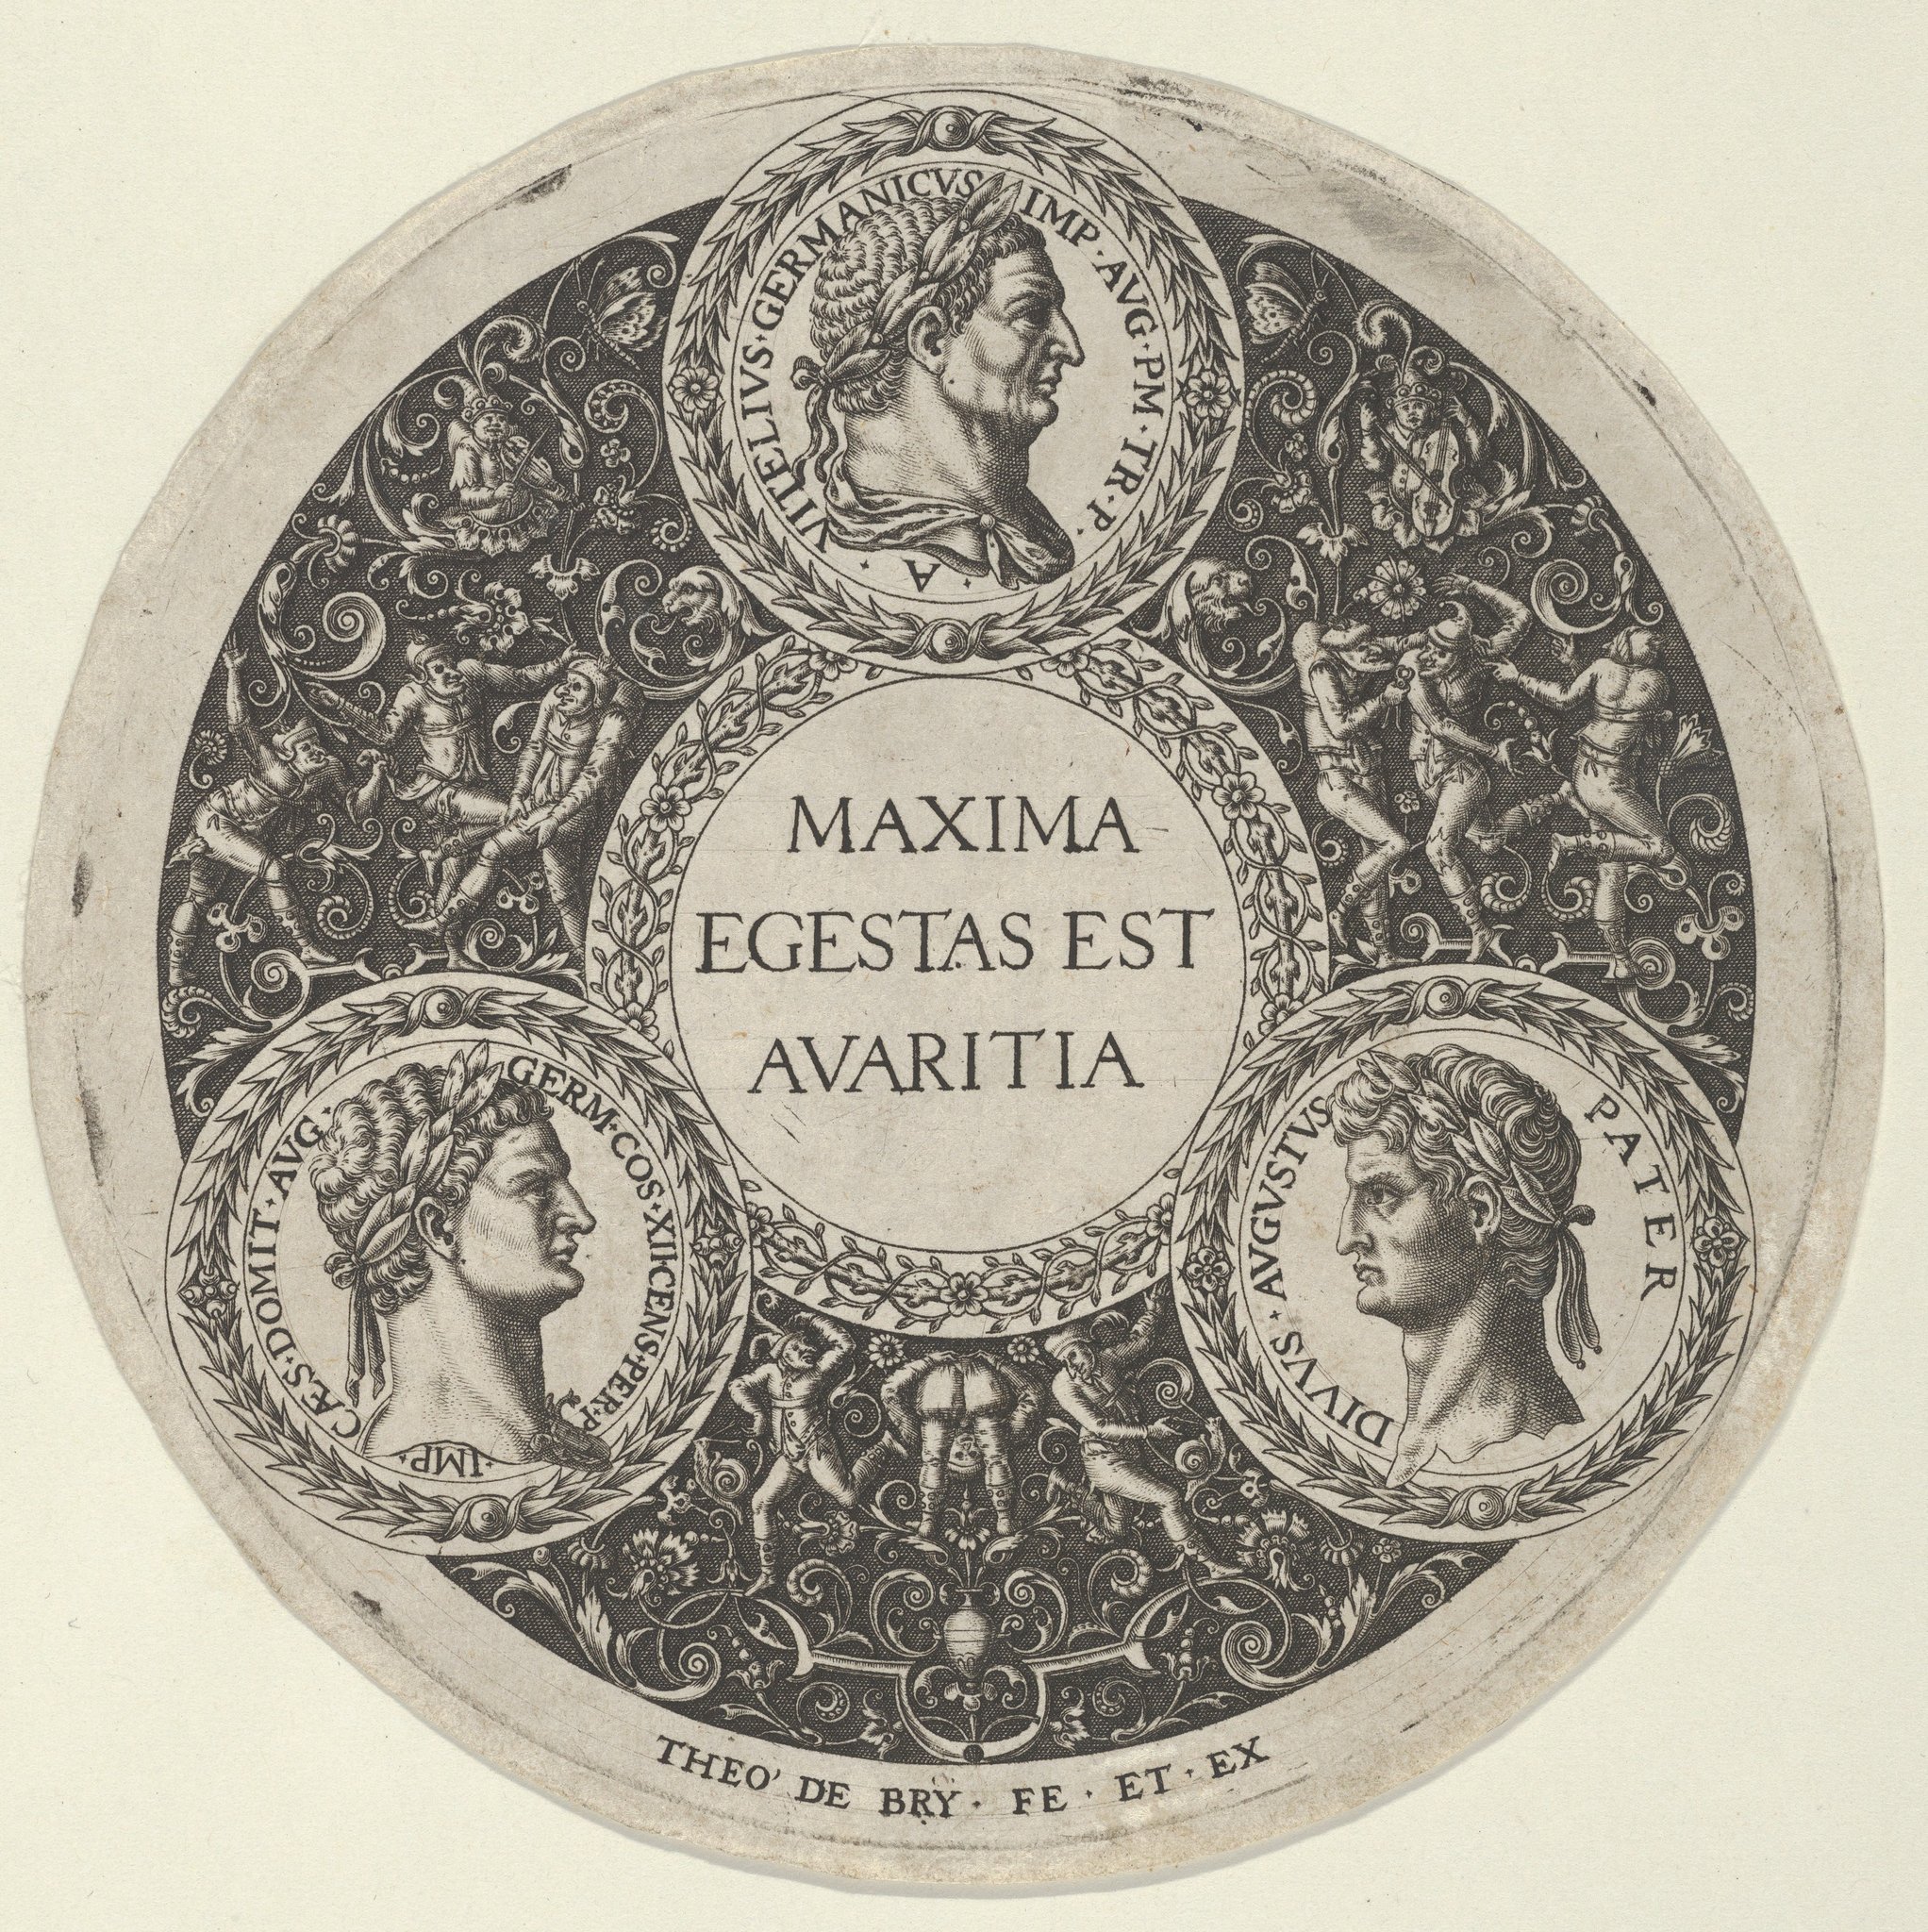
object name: print ornament architecture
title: Design for a Dish with Portraits of the Roman Emperors Vetllius, Domitian, and Augustus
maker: theodor de bry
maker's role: artist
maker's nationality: netherlandish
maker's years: 1528-1598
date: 1588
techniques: engraving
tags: emperor augustus,men,profiles